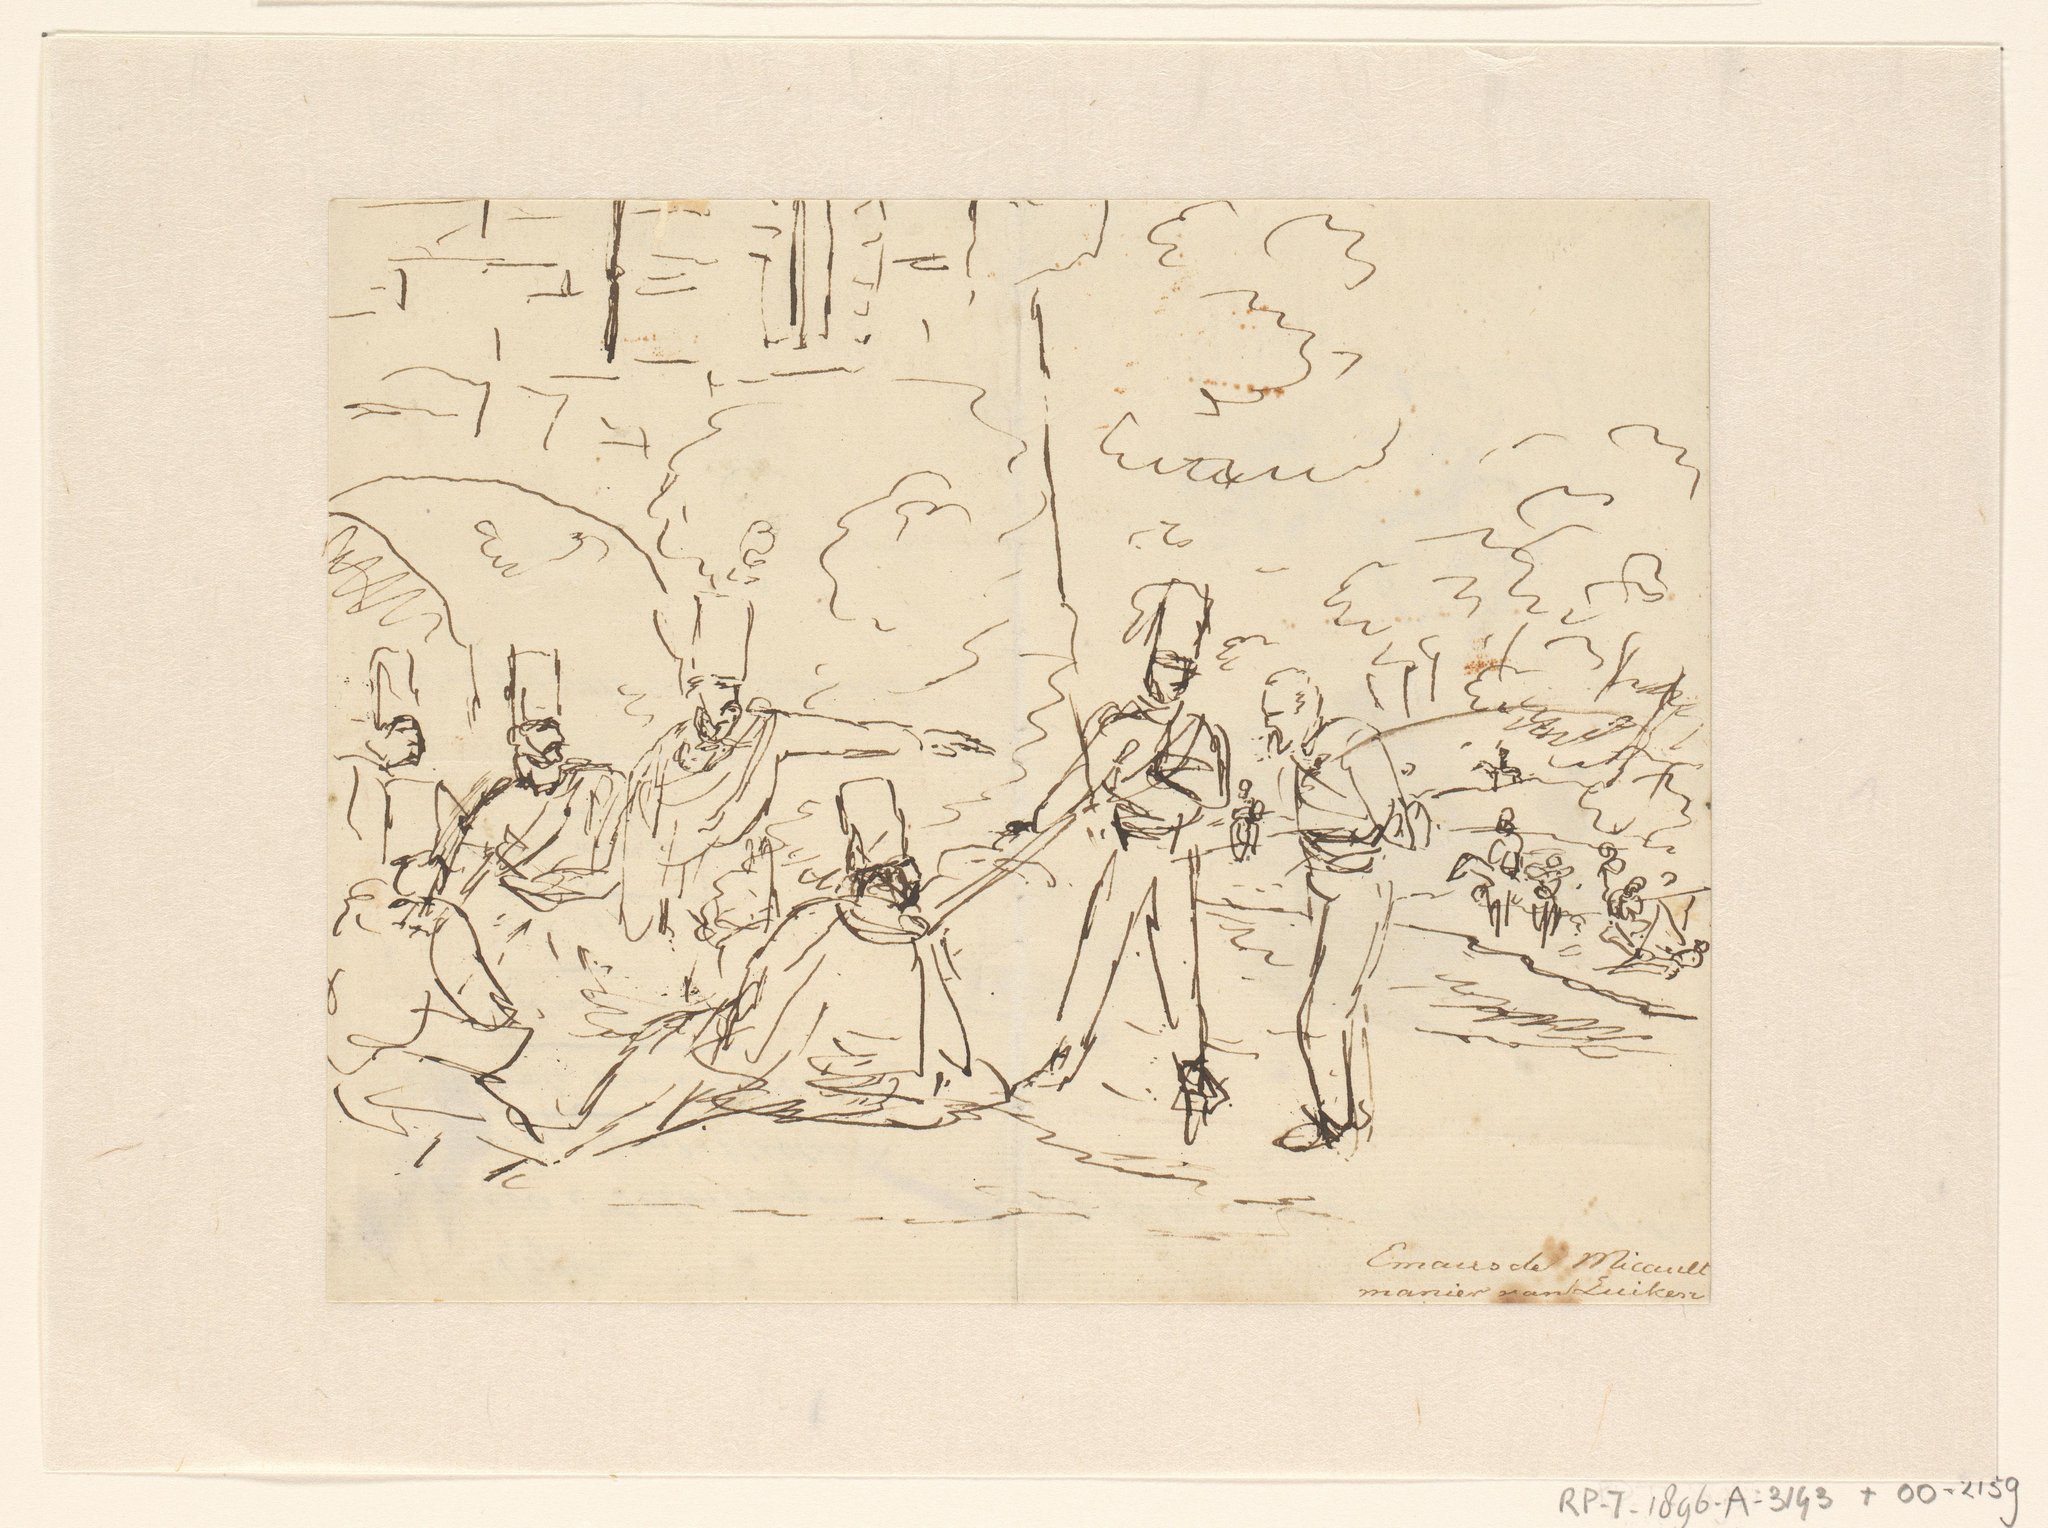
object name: drawing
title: Groep soldaten zittend en twee staande personen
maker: gerardus emaus de micault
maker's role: draughtsman, print maker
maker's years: 1798-1863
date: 1799-1863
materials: ink, paper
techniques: pen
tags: (military) camp with tents